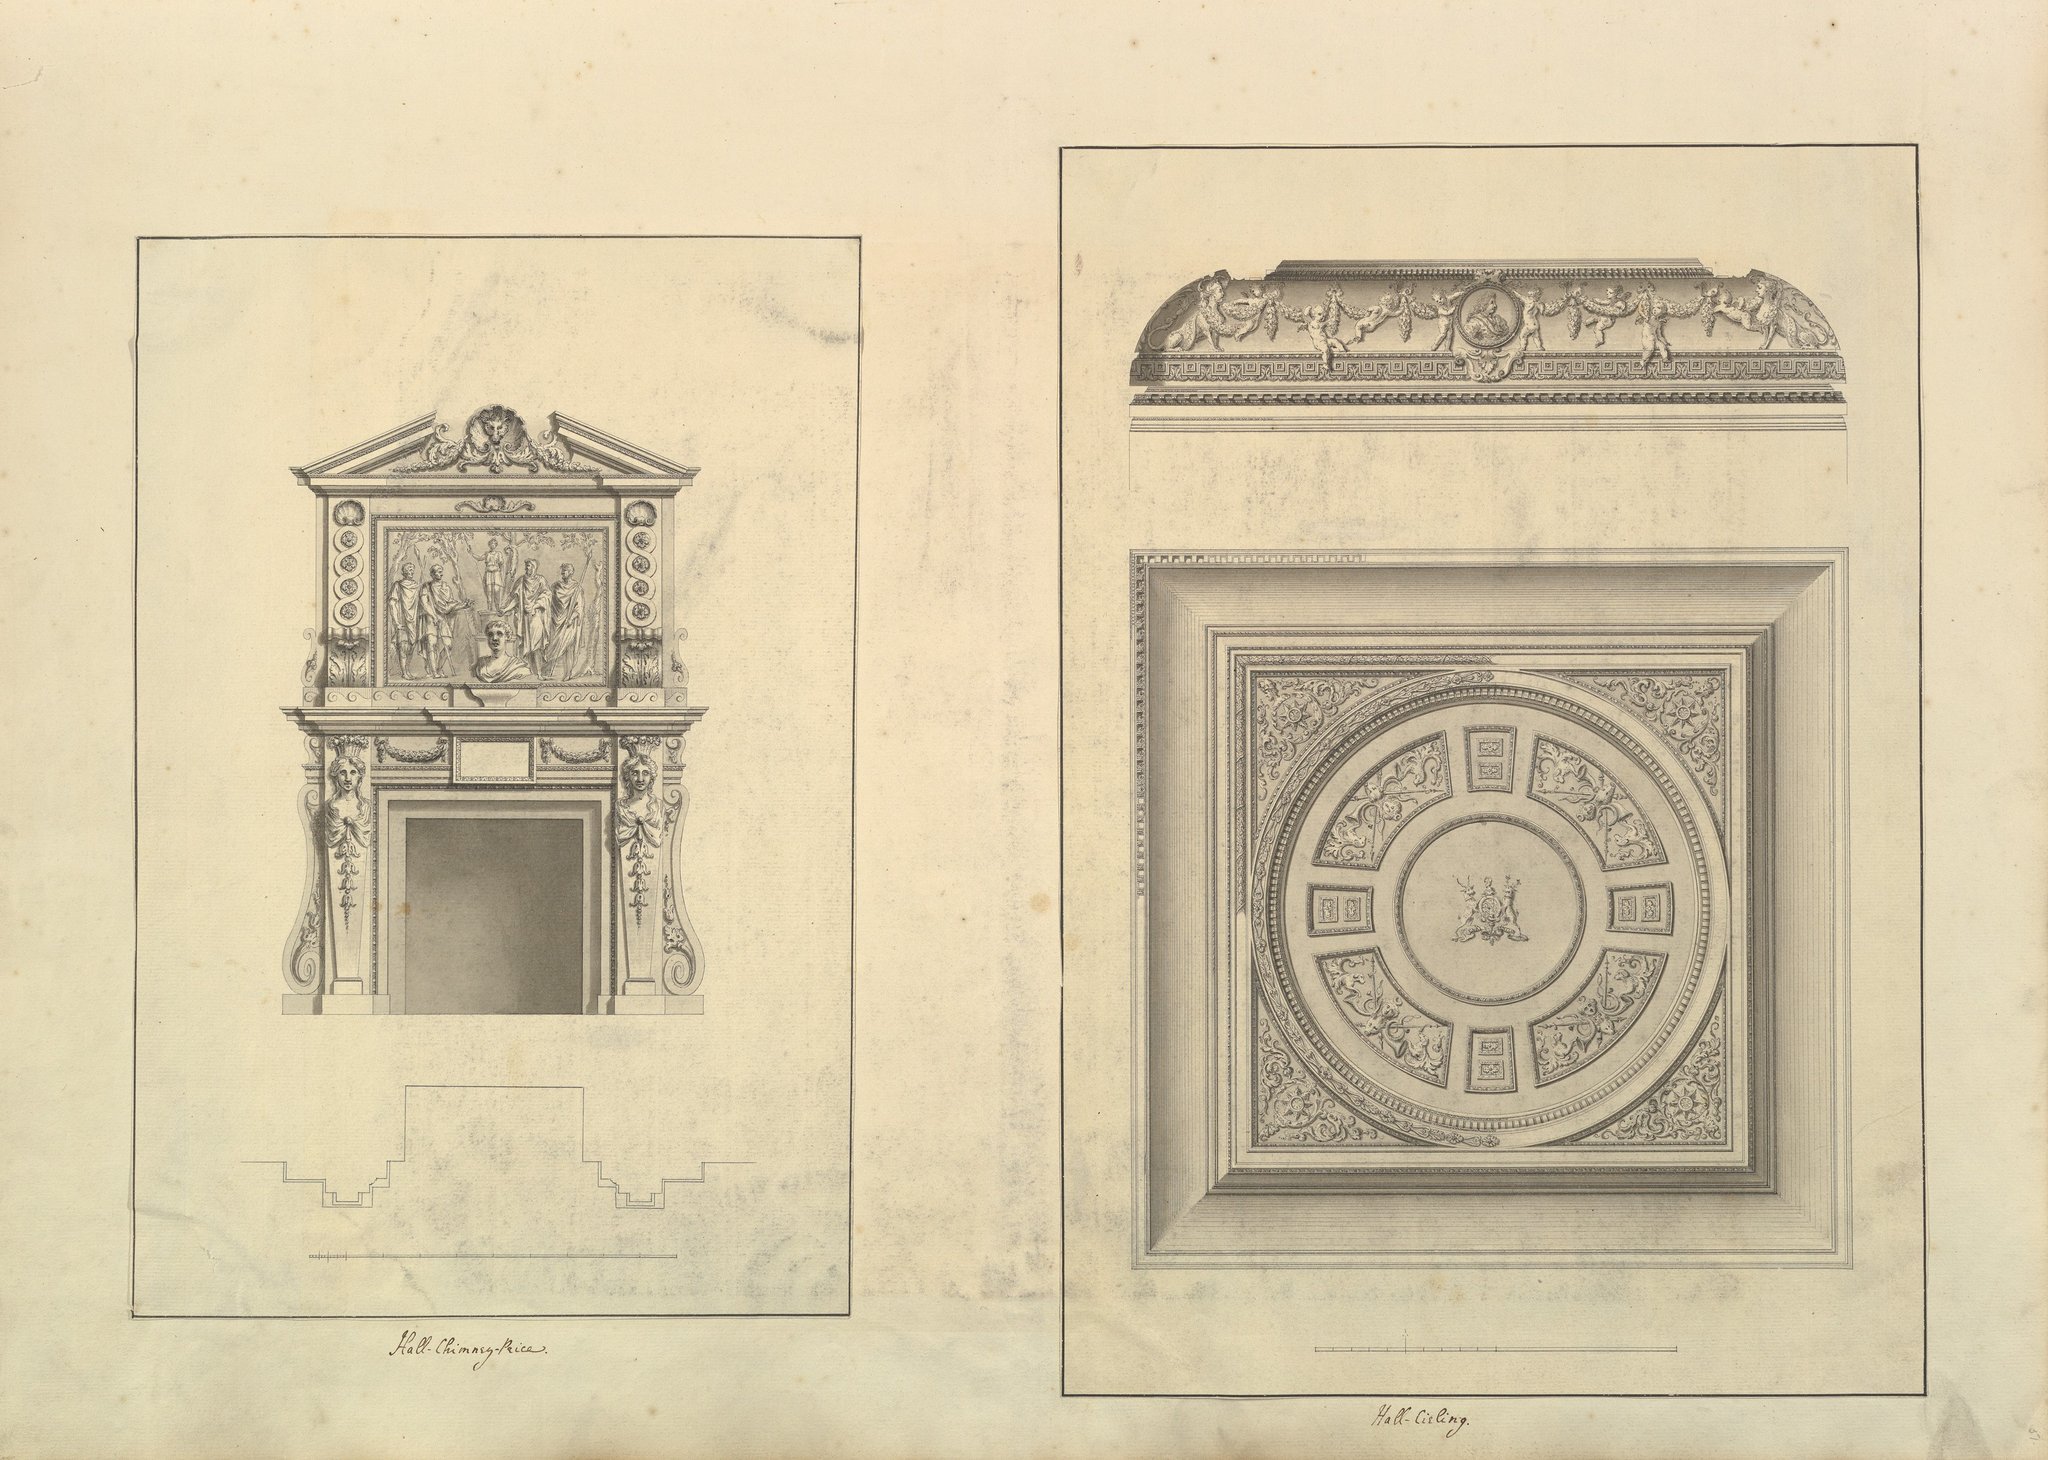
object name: drawing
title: Leaf from Aedes Walpolianae mounted with two drawings: (a): Hall Chimney-Piece, Houghton Hall, Norfolk; (b): Hall Ceiling, Houghton Hall, Norfolk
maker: isaac ware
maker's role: artist and architect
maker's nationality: british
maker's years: 1704-1766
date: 1735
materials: ink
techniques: brush, pen, wash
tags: architecture,fireplaces